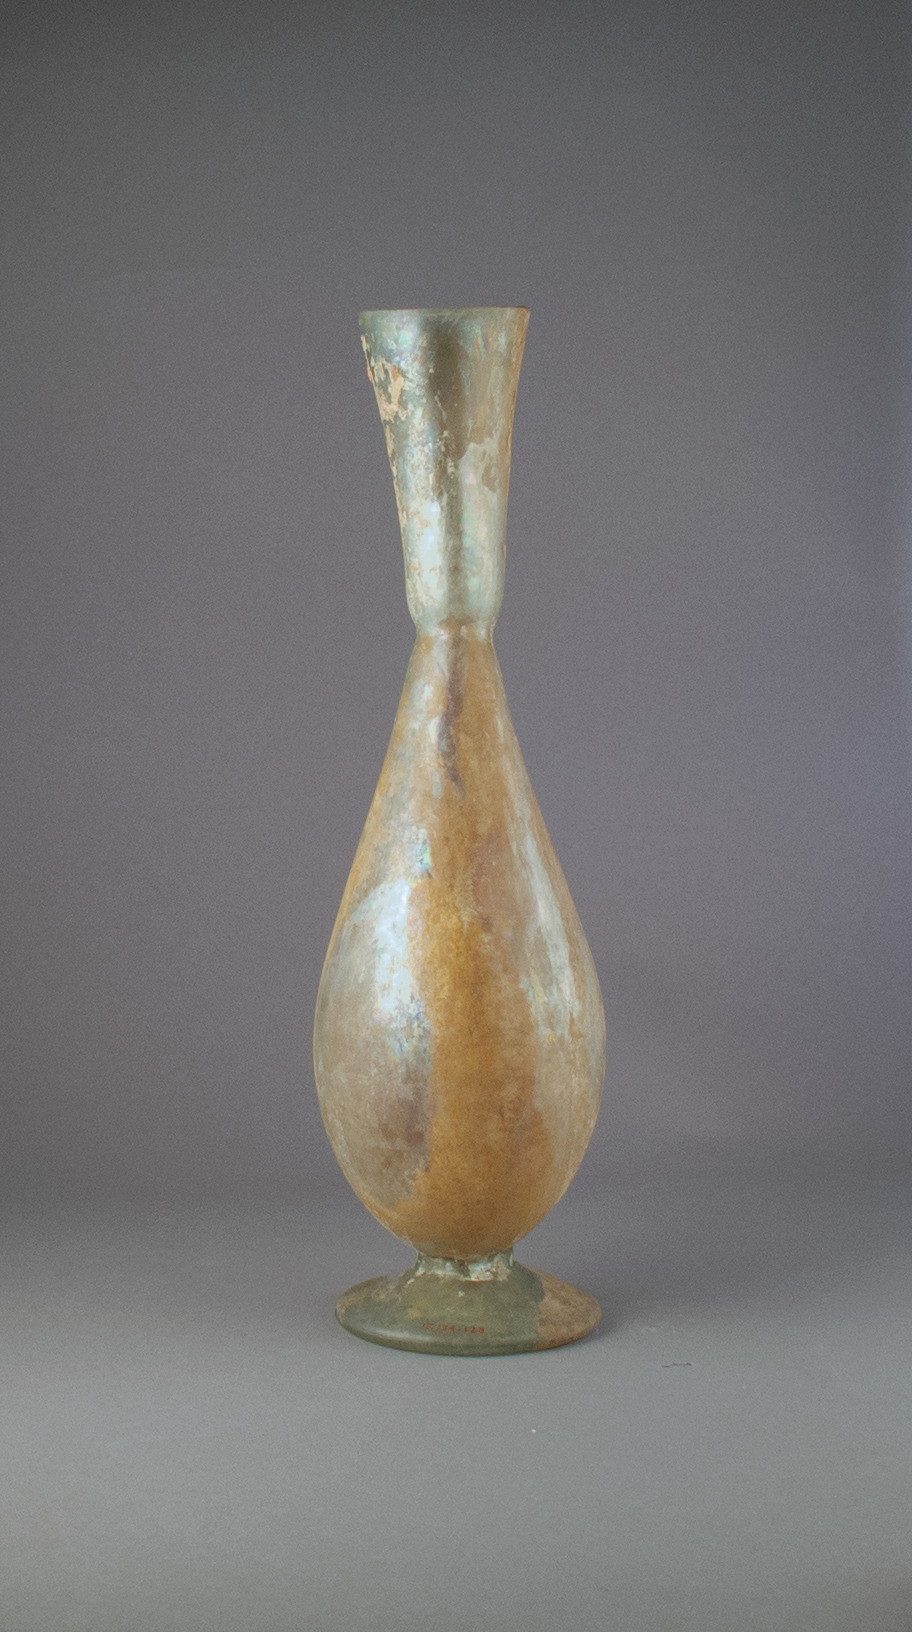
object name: flask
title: Glass flask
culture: roman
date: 201-400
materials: glass